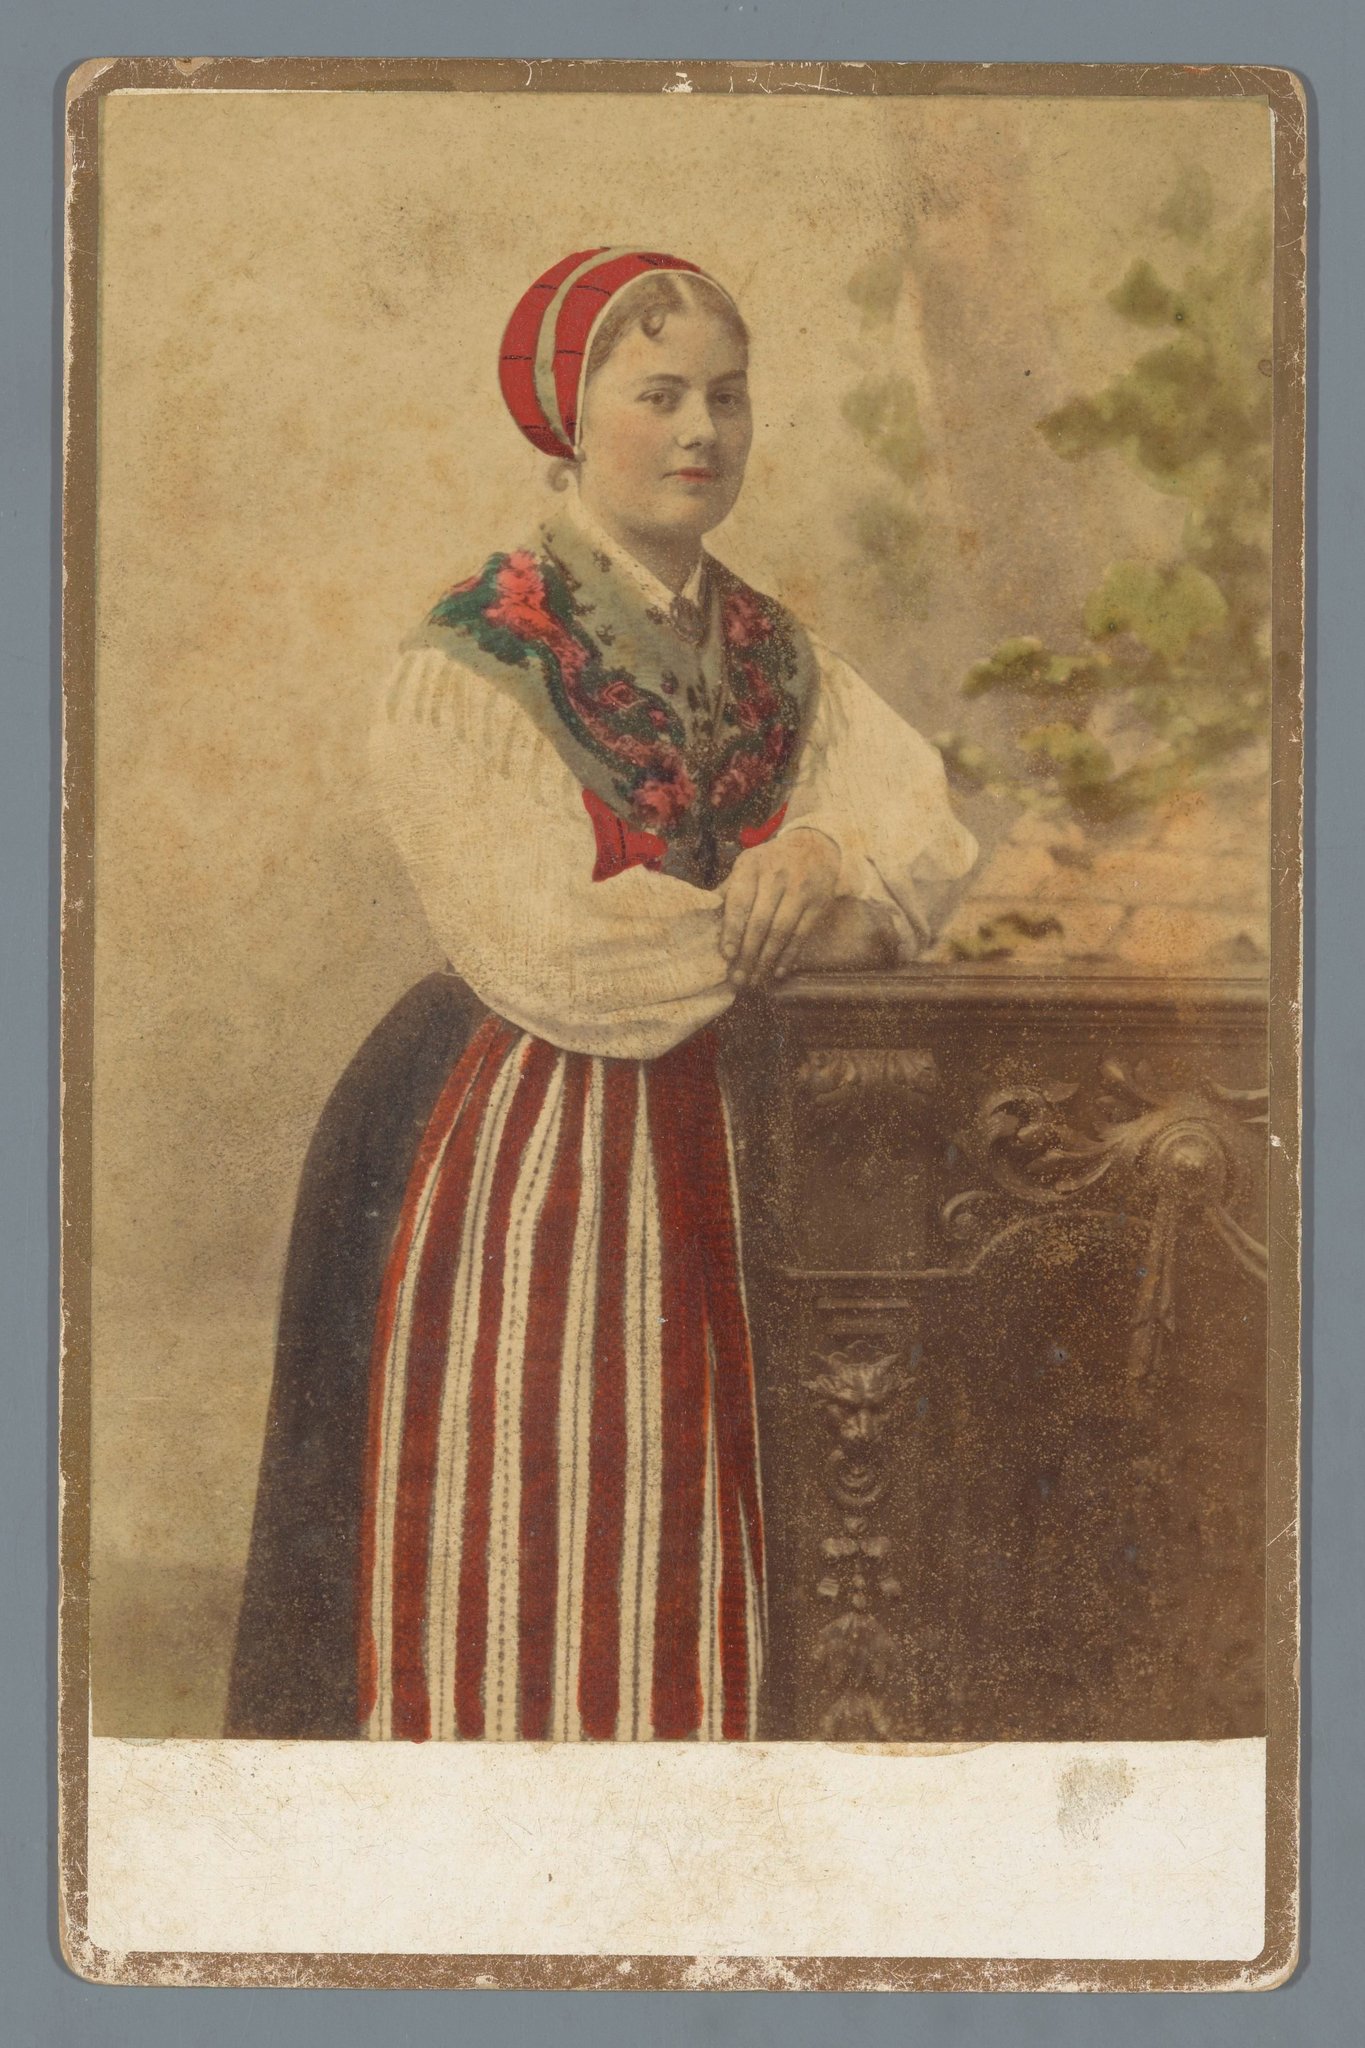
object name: cabinet photograph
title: Portret van een onbekende vrouw in klederdracht van vermoedelijk Rättvik in Zweden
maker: wilhelm abraham eurenius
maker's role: fotograaf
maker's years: -1892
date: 1870-1890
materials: cardboard, photographic support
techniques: albumen print, hand coloring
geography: stockholm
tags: folk costume, regional costume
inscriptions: name: ‘W. Eurenius, Kongl. Hoffotograf Stockholm Hamngatan No. 18. Juhre & Nicolai, Berlin.’, inscription: ‘Rattvik’